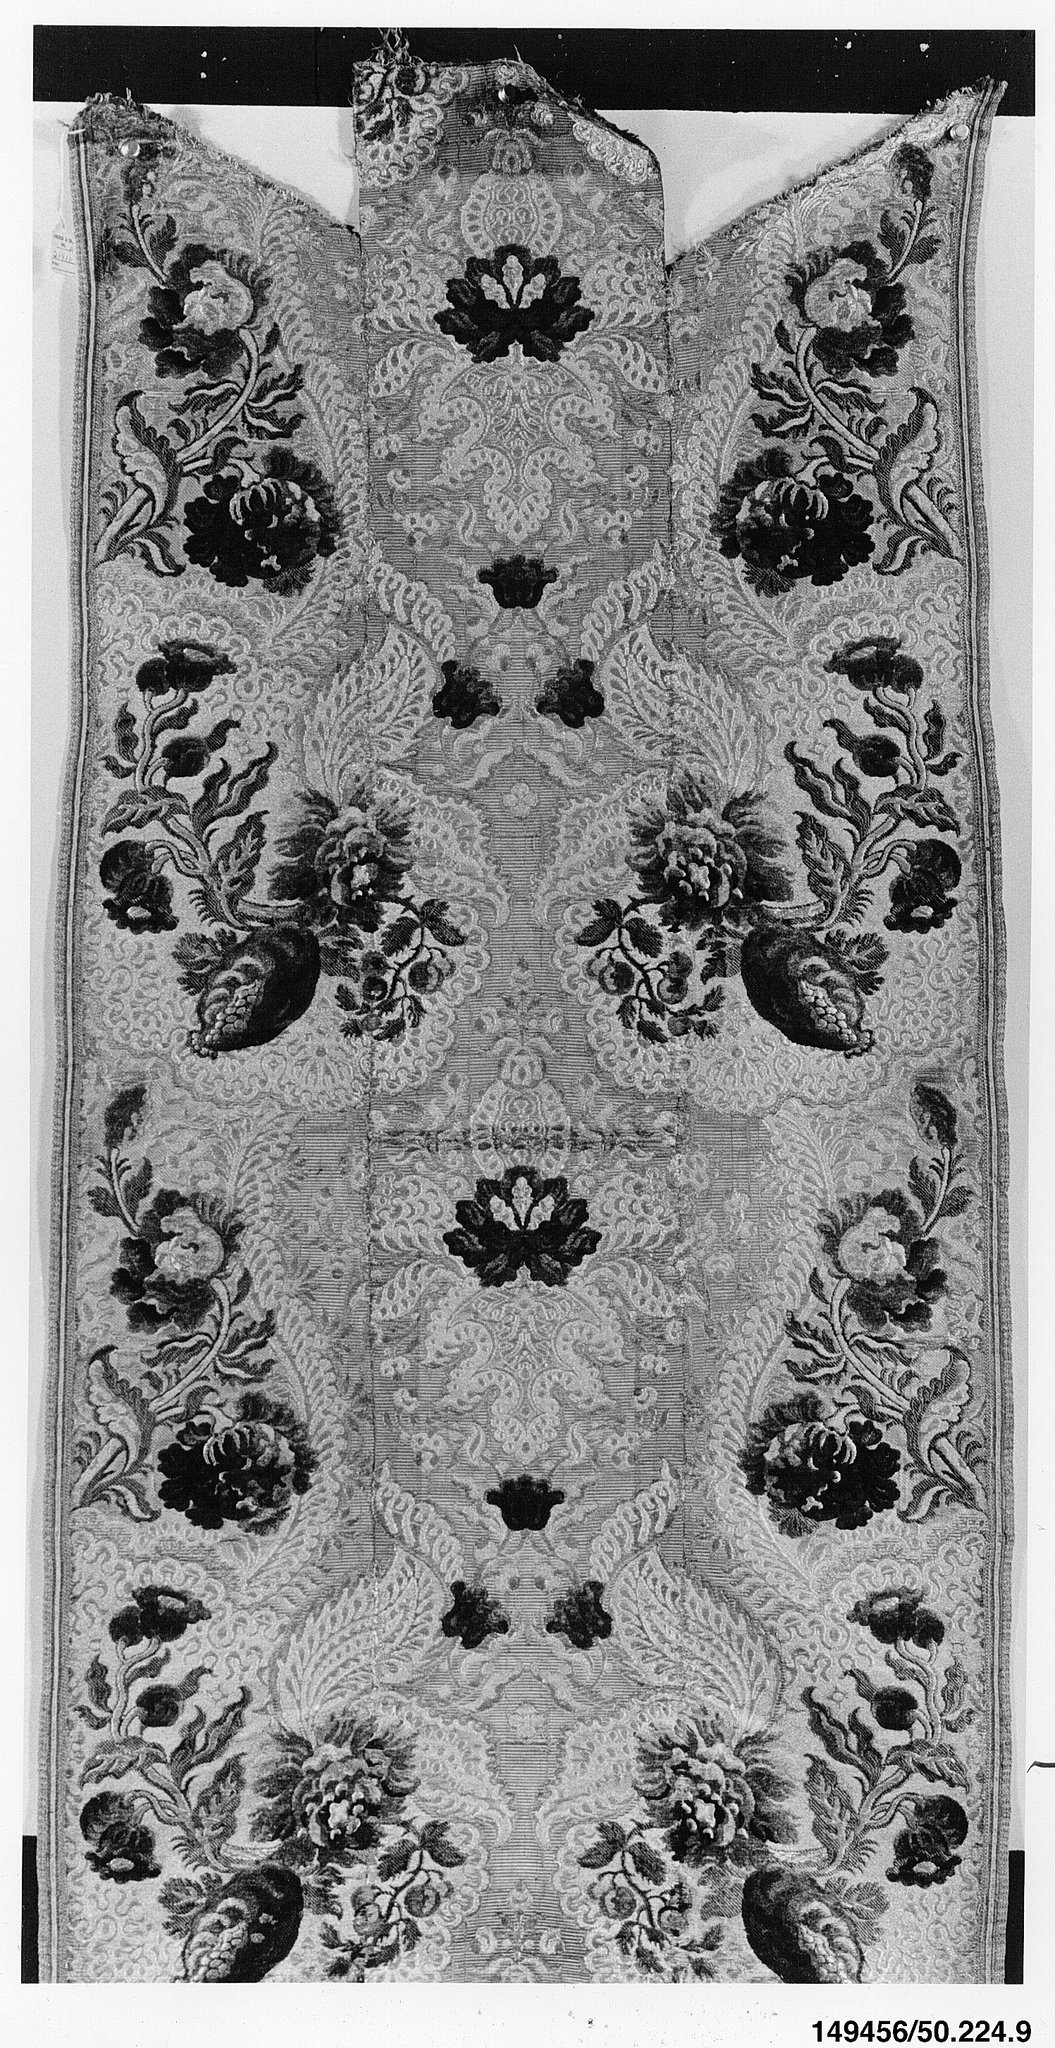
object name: piece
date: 1725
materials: metal, silk, thread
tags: flowers,leaves